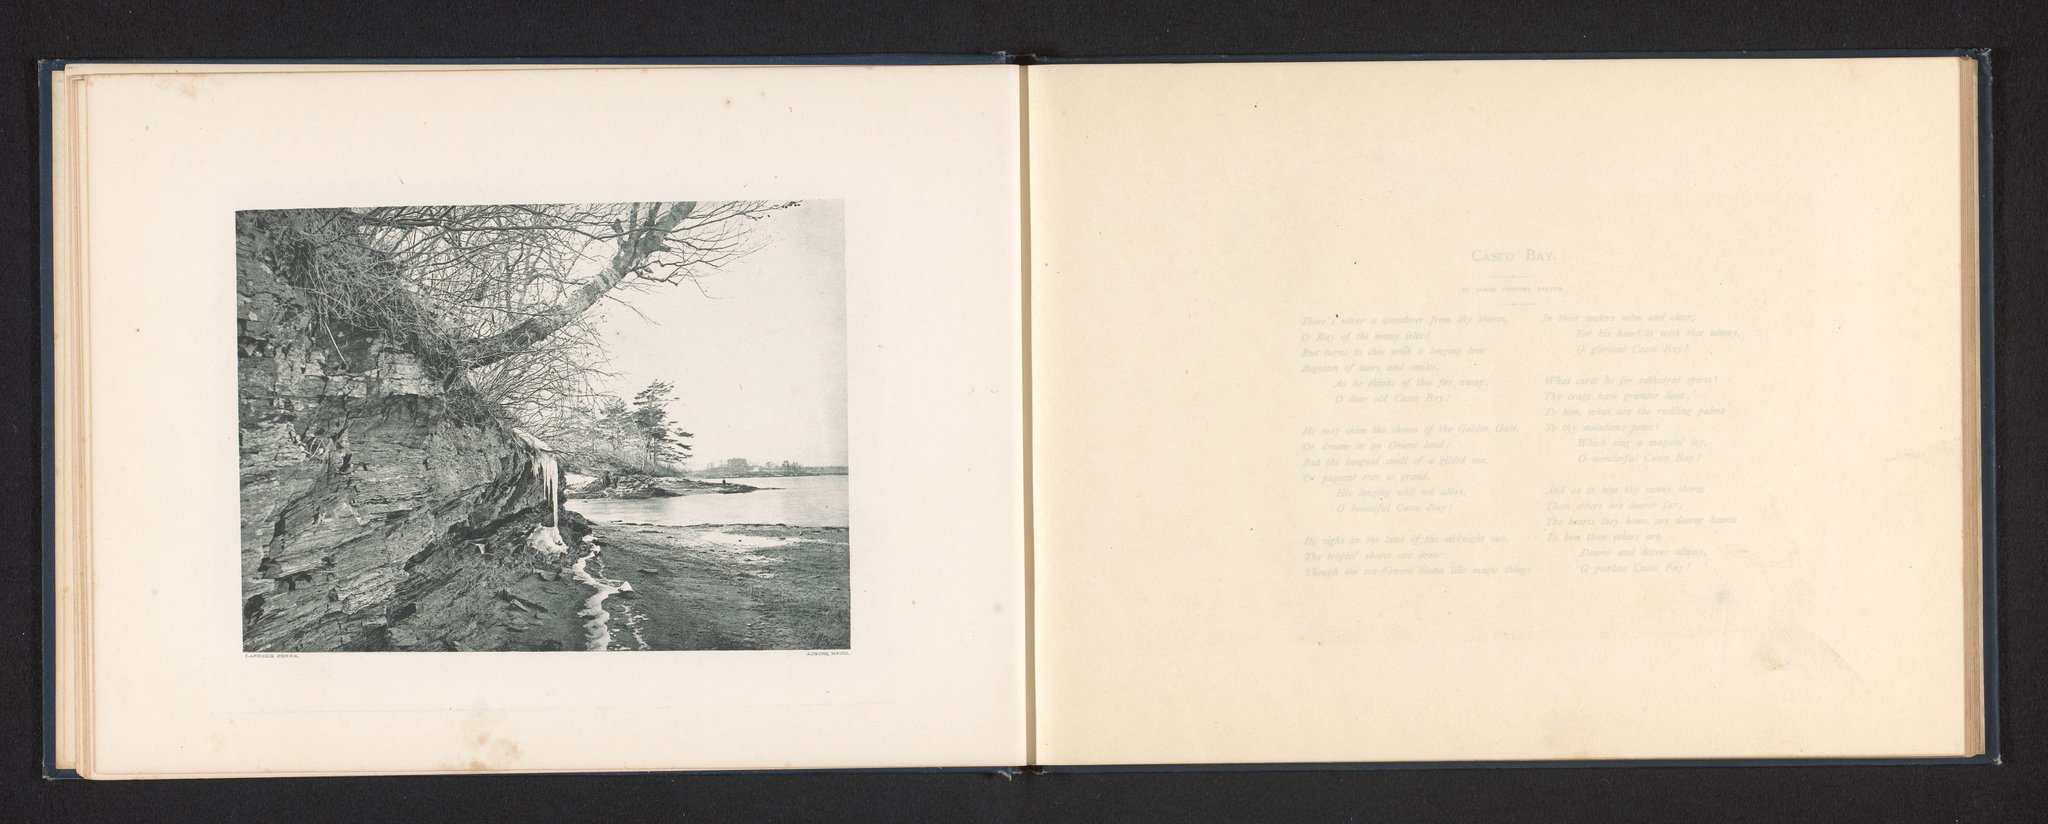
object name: page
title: Gezicht op Casco Bay aan de kust van Maine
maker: Anonymous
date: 1880-1890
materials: paper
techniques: photoaquatint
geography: casco bay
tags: gulf, bay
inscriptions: inscription: ‘Casco Bay. (...)’